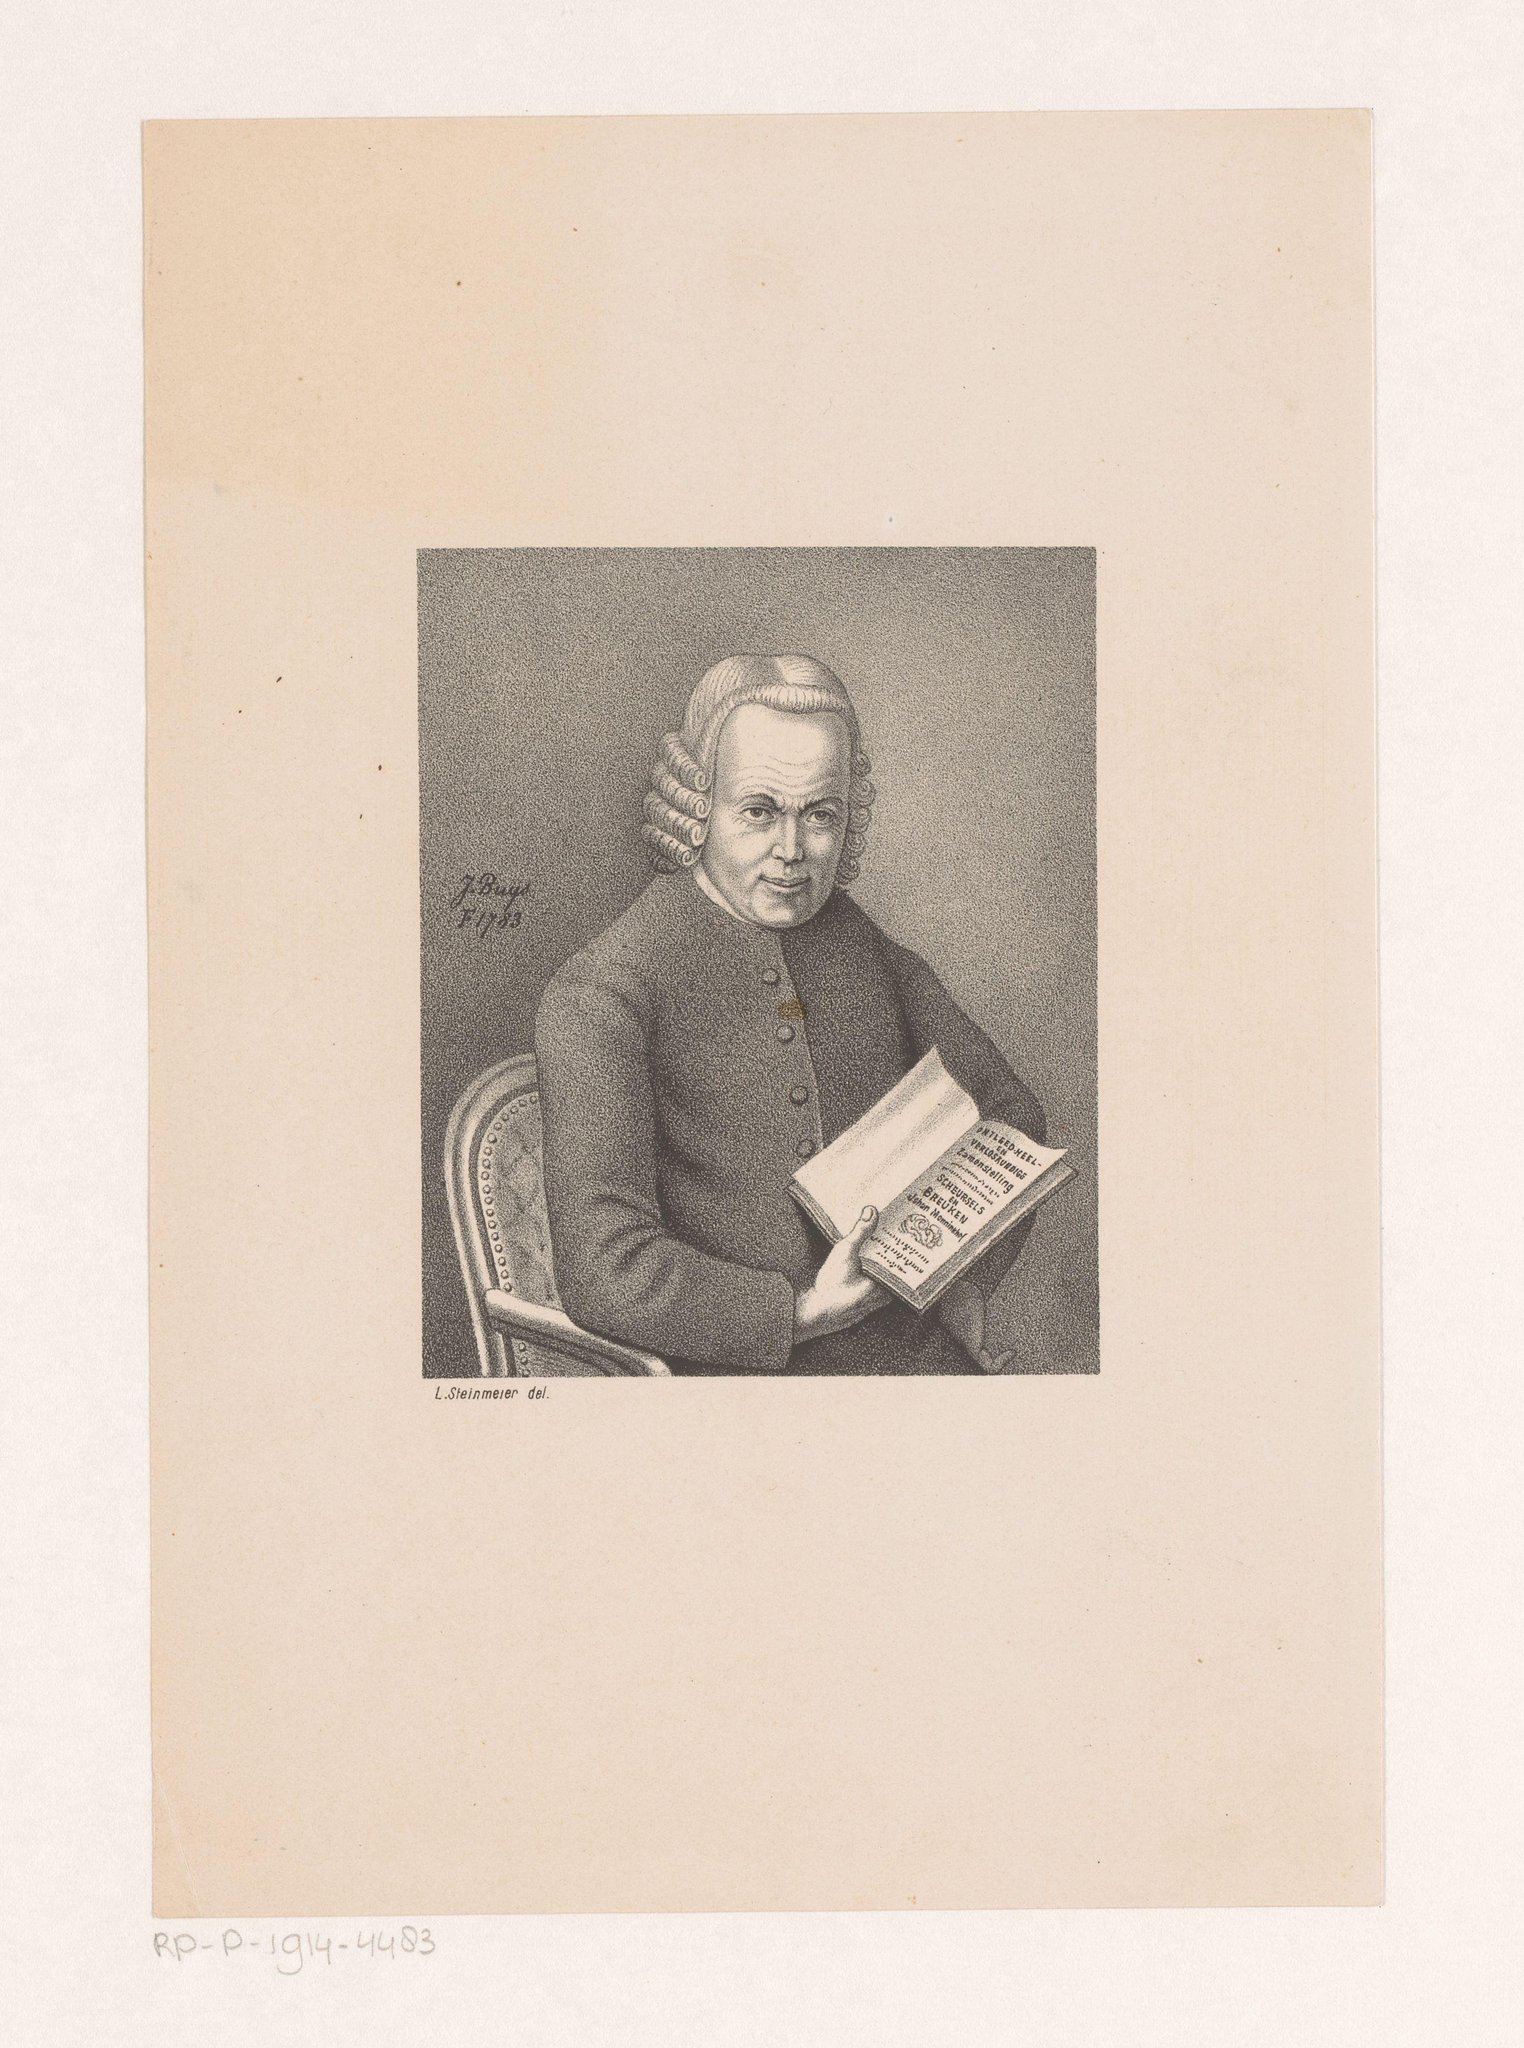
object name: print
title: Portret van Johannes Monnikhoff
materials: paper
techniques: lithograph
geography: leiden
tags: historical persons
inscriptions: collector's mark: Lugt 2228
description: Proefdruk voor prent uit: Wintgens, Eduard. Johannes Monnikhoff en zijn legaat. Leiden: Somerwil, P., 1879.